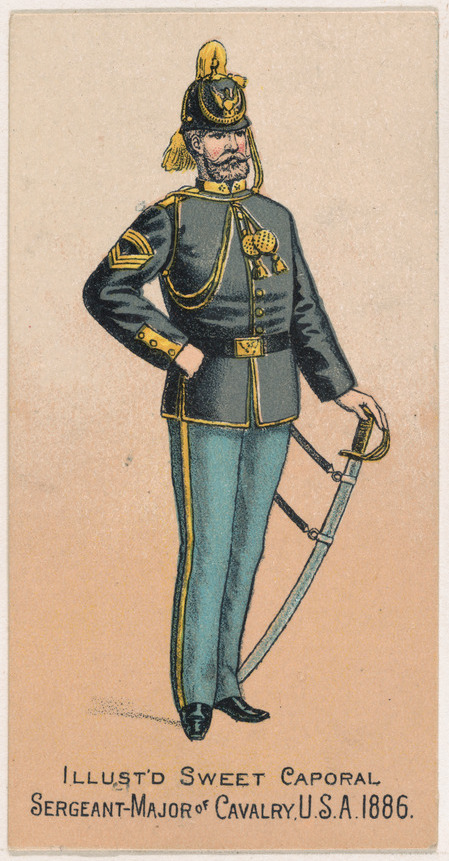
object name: print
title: Sergeant-Major of Cavalry, United States Army, 1886, from the Military Series (N224) issued by Kinney Tobacco Company to promote Sweet Caporal Cigarettes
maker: kinney brothers tobacco company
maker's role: publisher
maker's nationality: american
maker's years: 1869-2011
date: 1888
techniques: color lithograph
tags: soldiers,swords,men